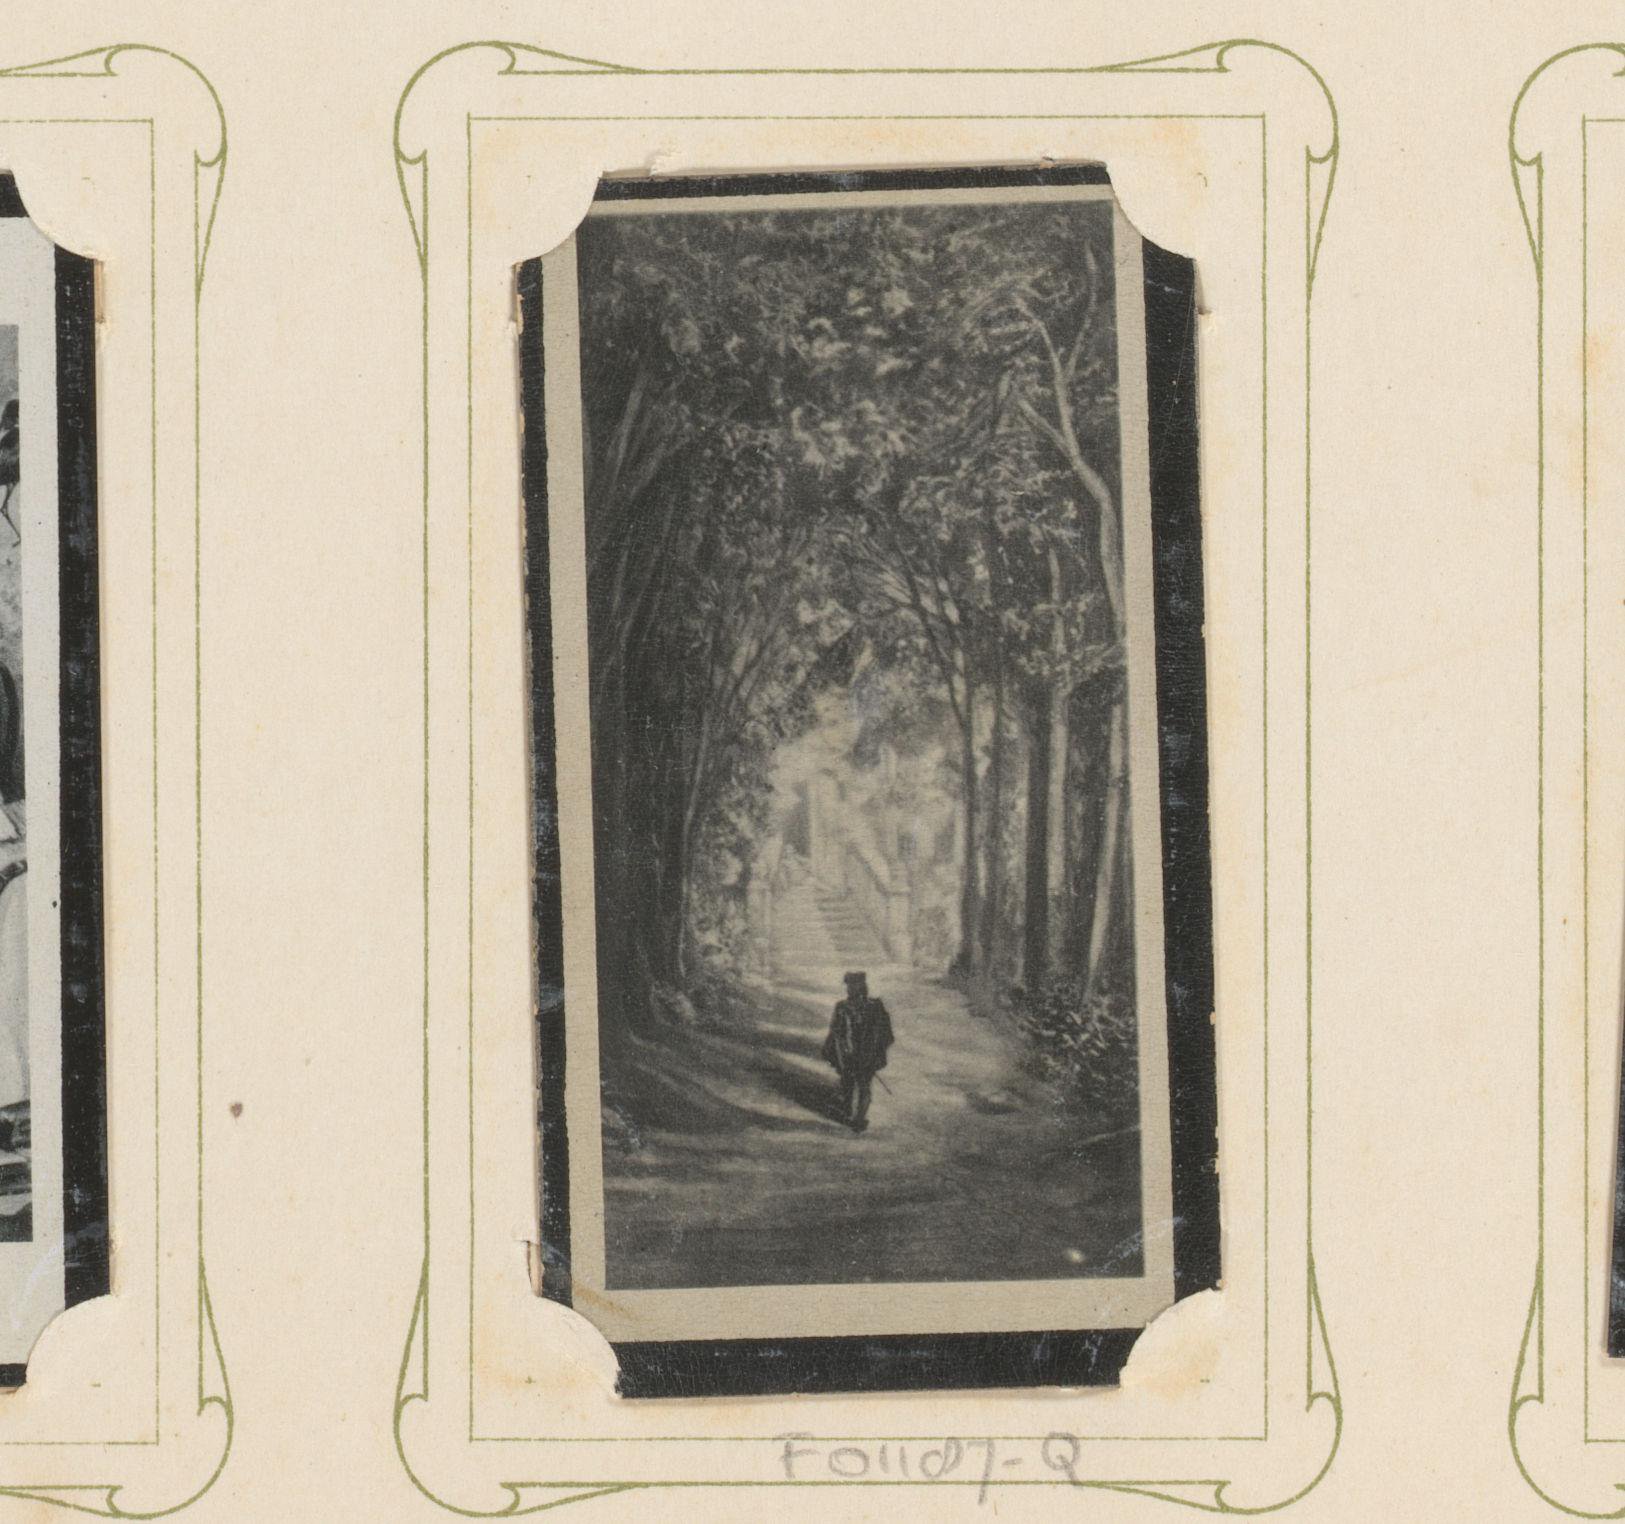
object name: album leaf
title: Reproductie van een tekening van de prins van Doornroosje voor het betoverde kasteel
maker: Anonymous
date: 1905-1906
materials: paper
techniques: photograph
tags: castle, tales and fairy tales: sleeping beauty, prince, forest path or lane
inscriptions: inscription: ‘No. 11./ De prins voor het betooverde kasteel.’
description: Deze prent maakt deel uit van een album.